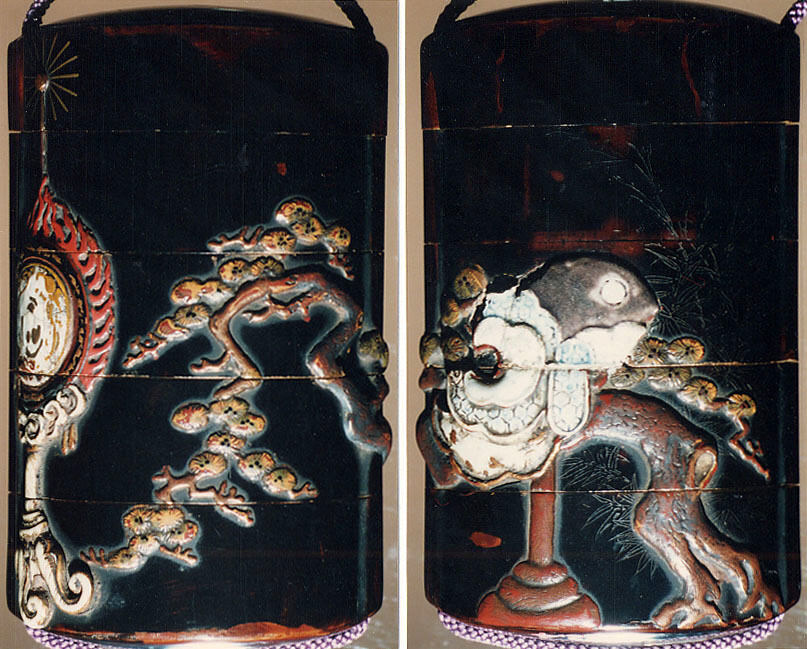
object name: inrō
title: Case (Inrō) with Design of Bugaku Dance Hat on Stand beside Pine Tree (obverse); Dance Drum (reverse)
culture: japanese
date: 1701-1800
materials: ceramic, gold, lacquer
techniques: fundame, incising, inlay, roiro, maki-e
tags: hats,trees